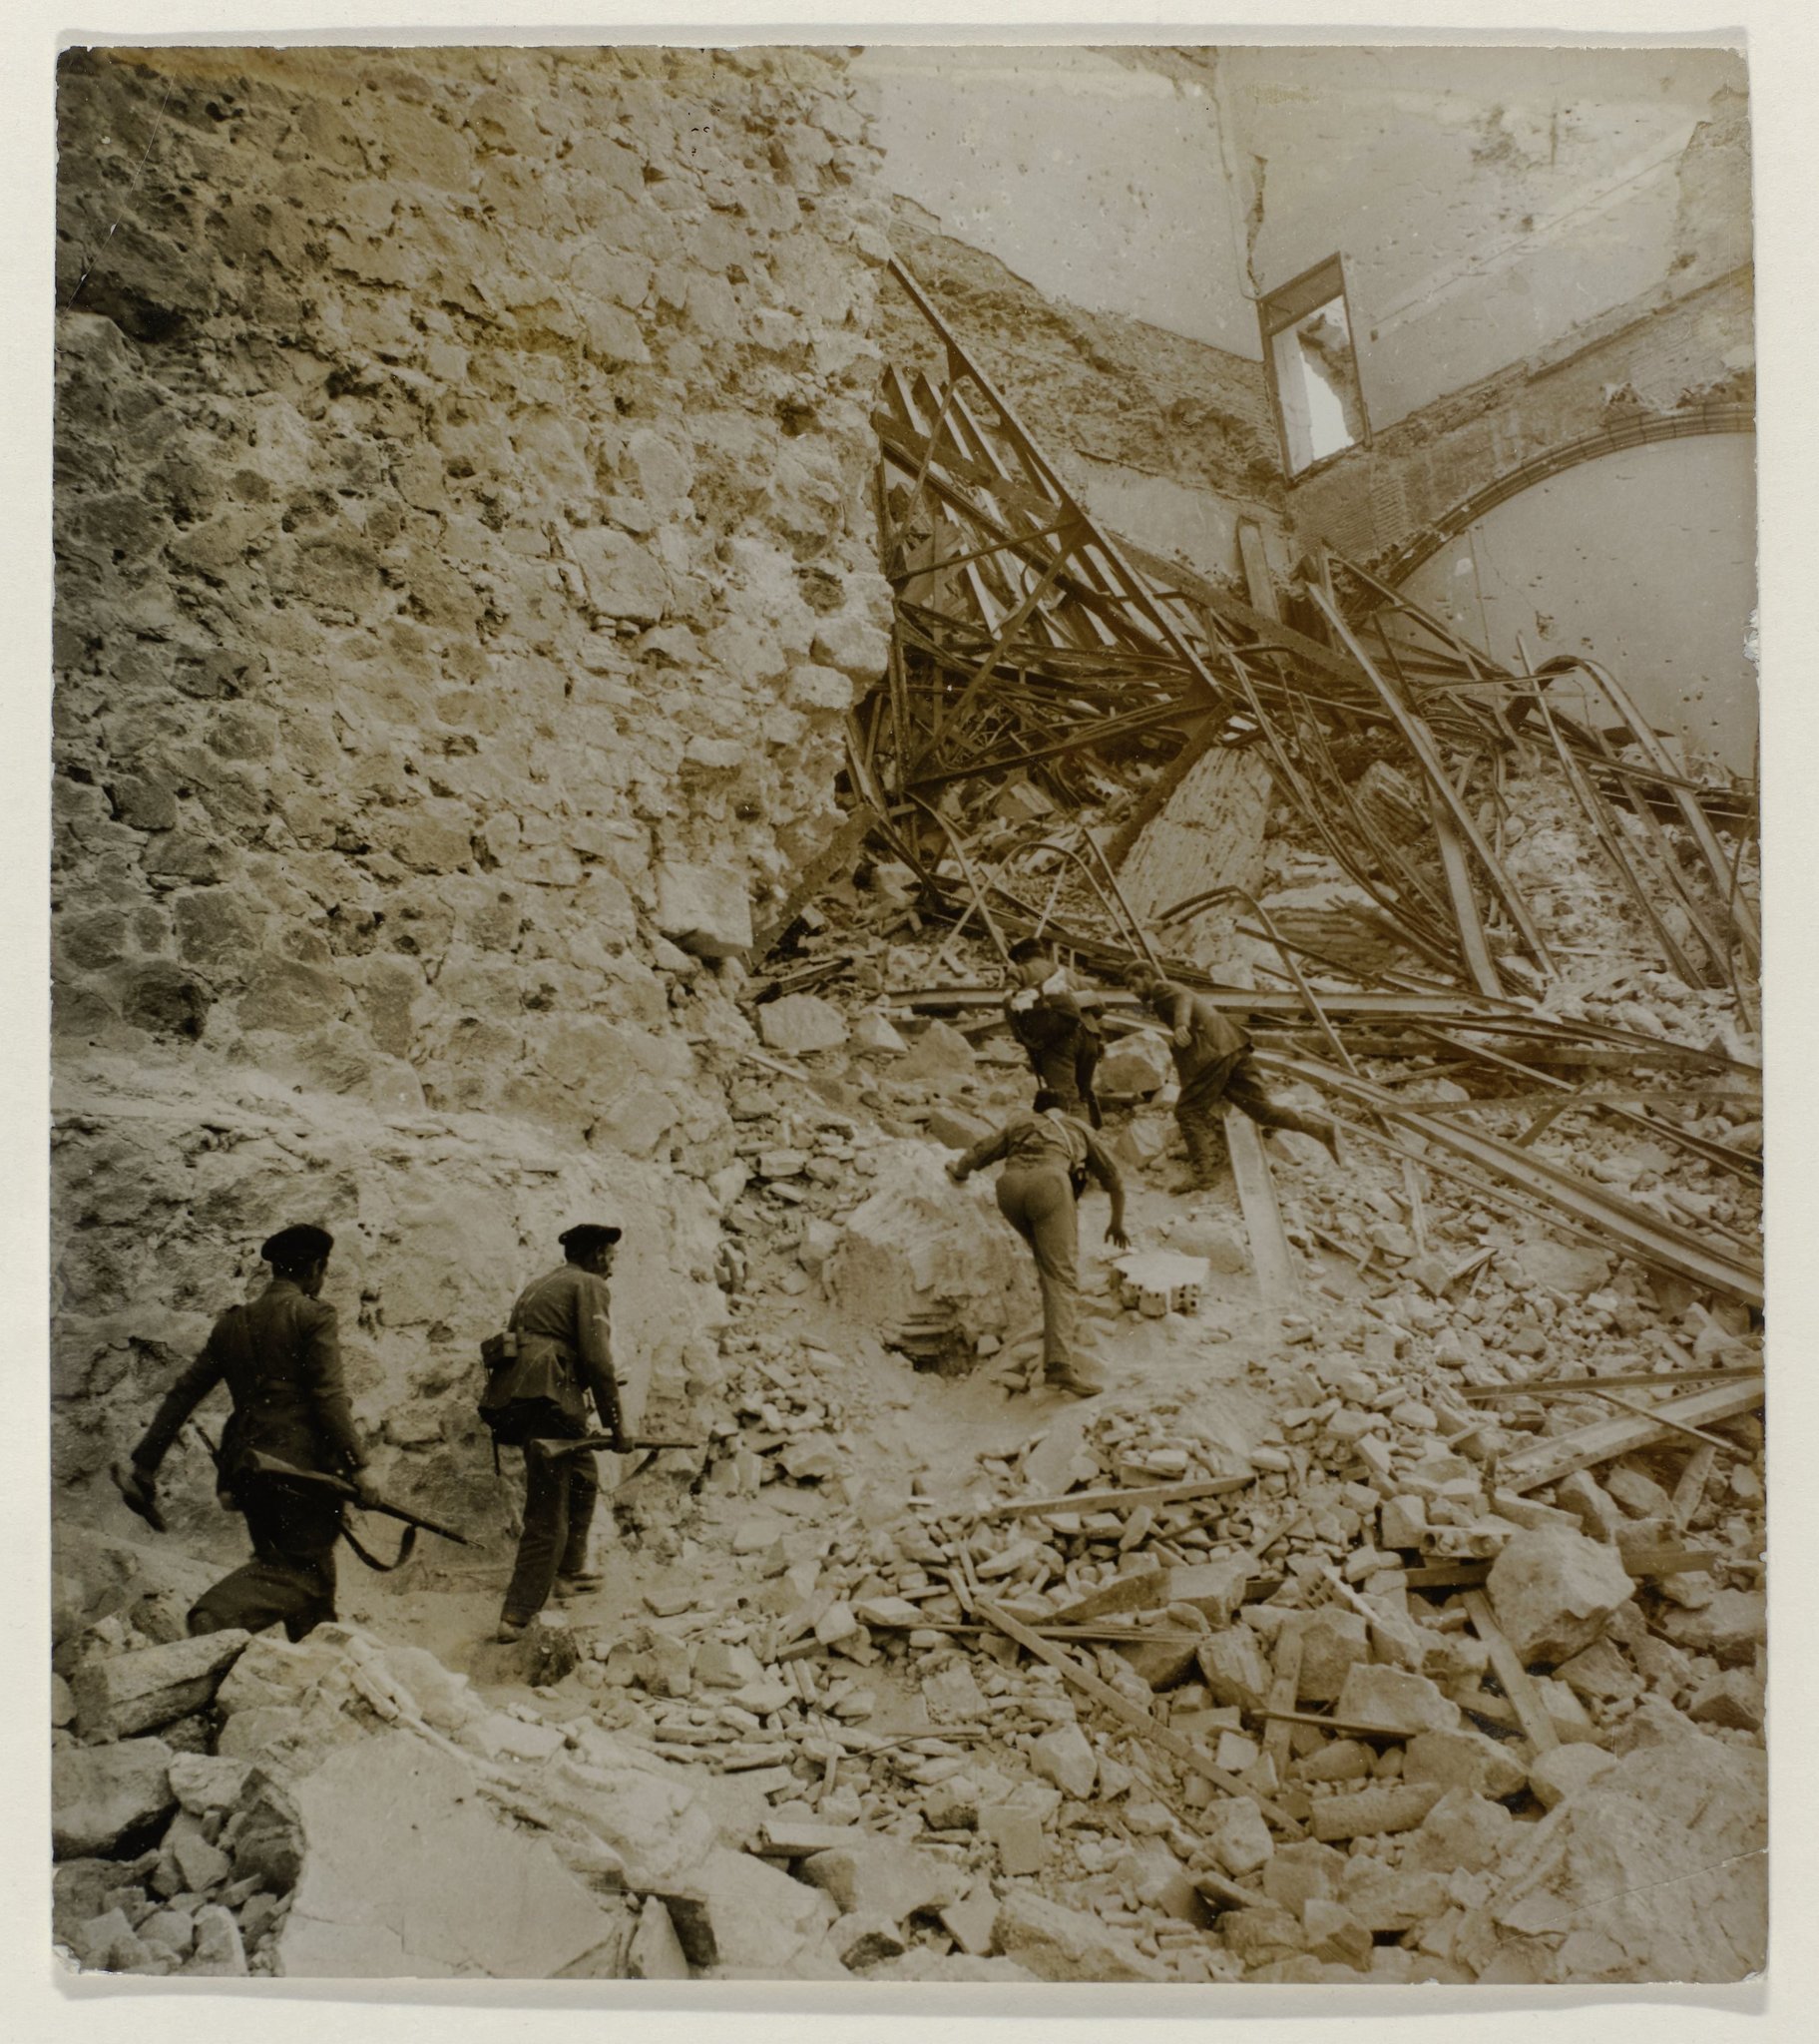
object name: photograph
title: In den Trümmern des Alkazar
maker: Anonymous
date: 1936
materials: photographic support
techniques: gelatin silver print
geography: berlin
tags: toledo, spaanse burgeroorlog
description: Nationalistische soldaten lopen door de ruïnes van het Alcázar in Toledo, tijdens het beleg door de republikeinen in de zomer van 1936 tijdens de Spaanse Burgeroorlog. Op de achterzijde stempels en blaadje met perstekst in het Duits.